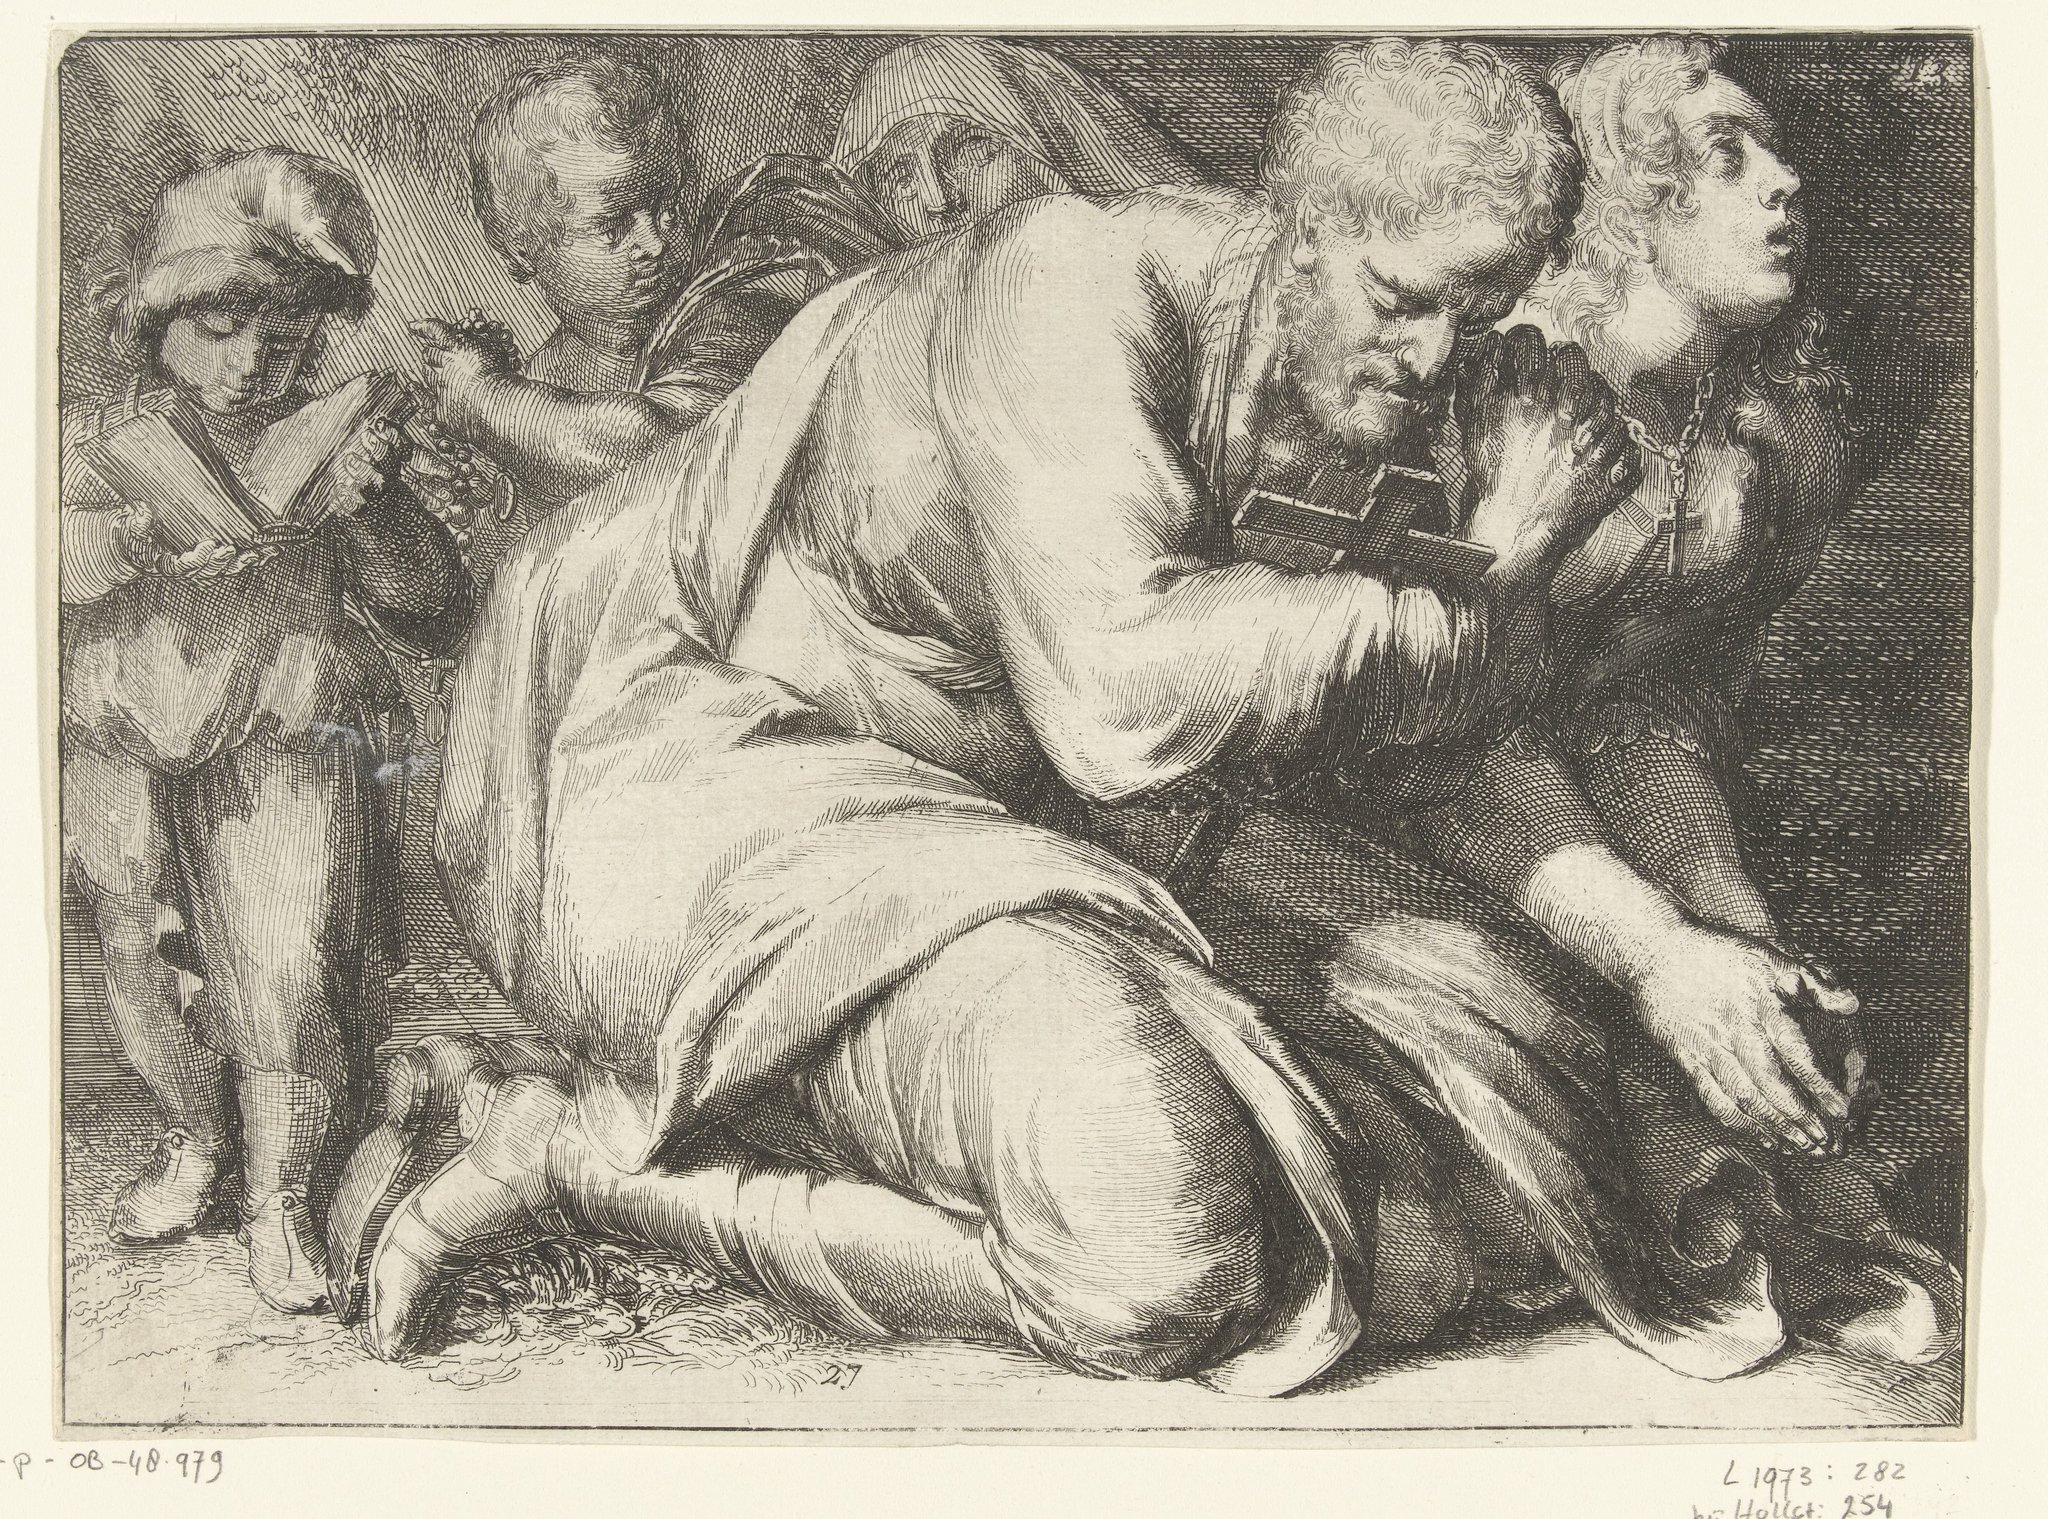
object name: print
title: Bekeerden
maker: romeyn de hooghe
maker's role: draughtsman, goldsmith, painter, print maker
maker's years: 1645-1708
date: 1700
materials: paper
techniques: etching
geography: haarlem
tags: military orders, e.g.: knights templars, knights of malta, teutonic knights ~ roman catholic church, conversion and belief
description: Een man met een kruis in de arm en een vrouw met een kruis om de nek bidden knielend. Achter hen twee kinderfiguurtjes en het hoofd van een vrouw (non?). Deze prent maakt deel uit van een omvangrijke voorstelling, samengesteld uit 20 afzonderlijke platen, van de geschiedenis en de werken van de Duitse Orde (midden) omgeven door voorstellingen van de landcommanderij Alden Biesen (onderaan) en de daarbij behorende commanderijen (links en rechts).